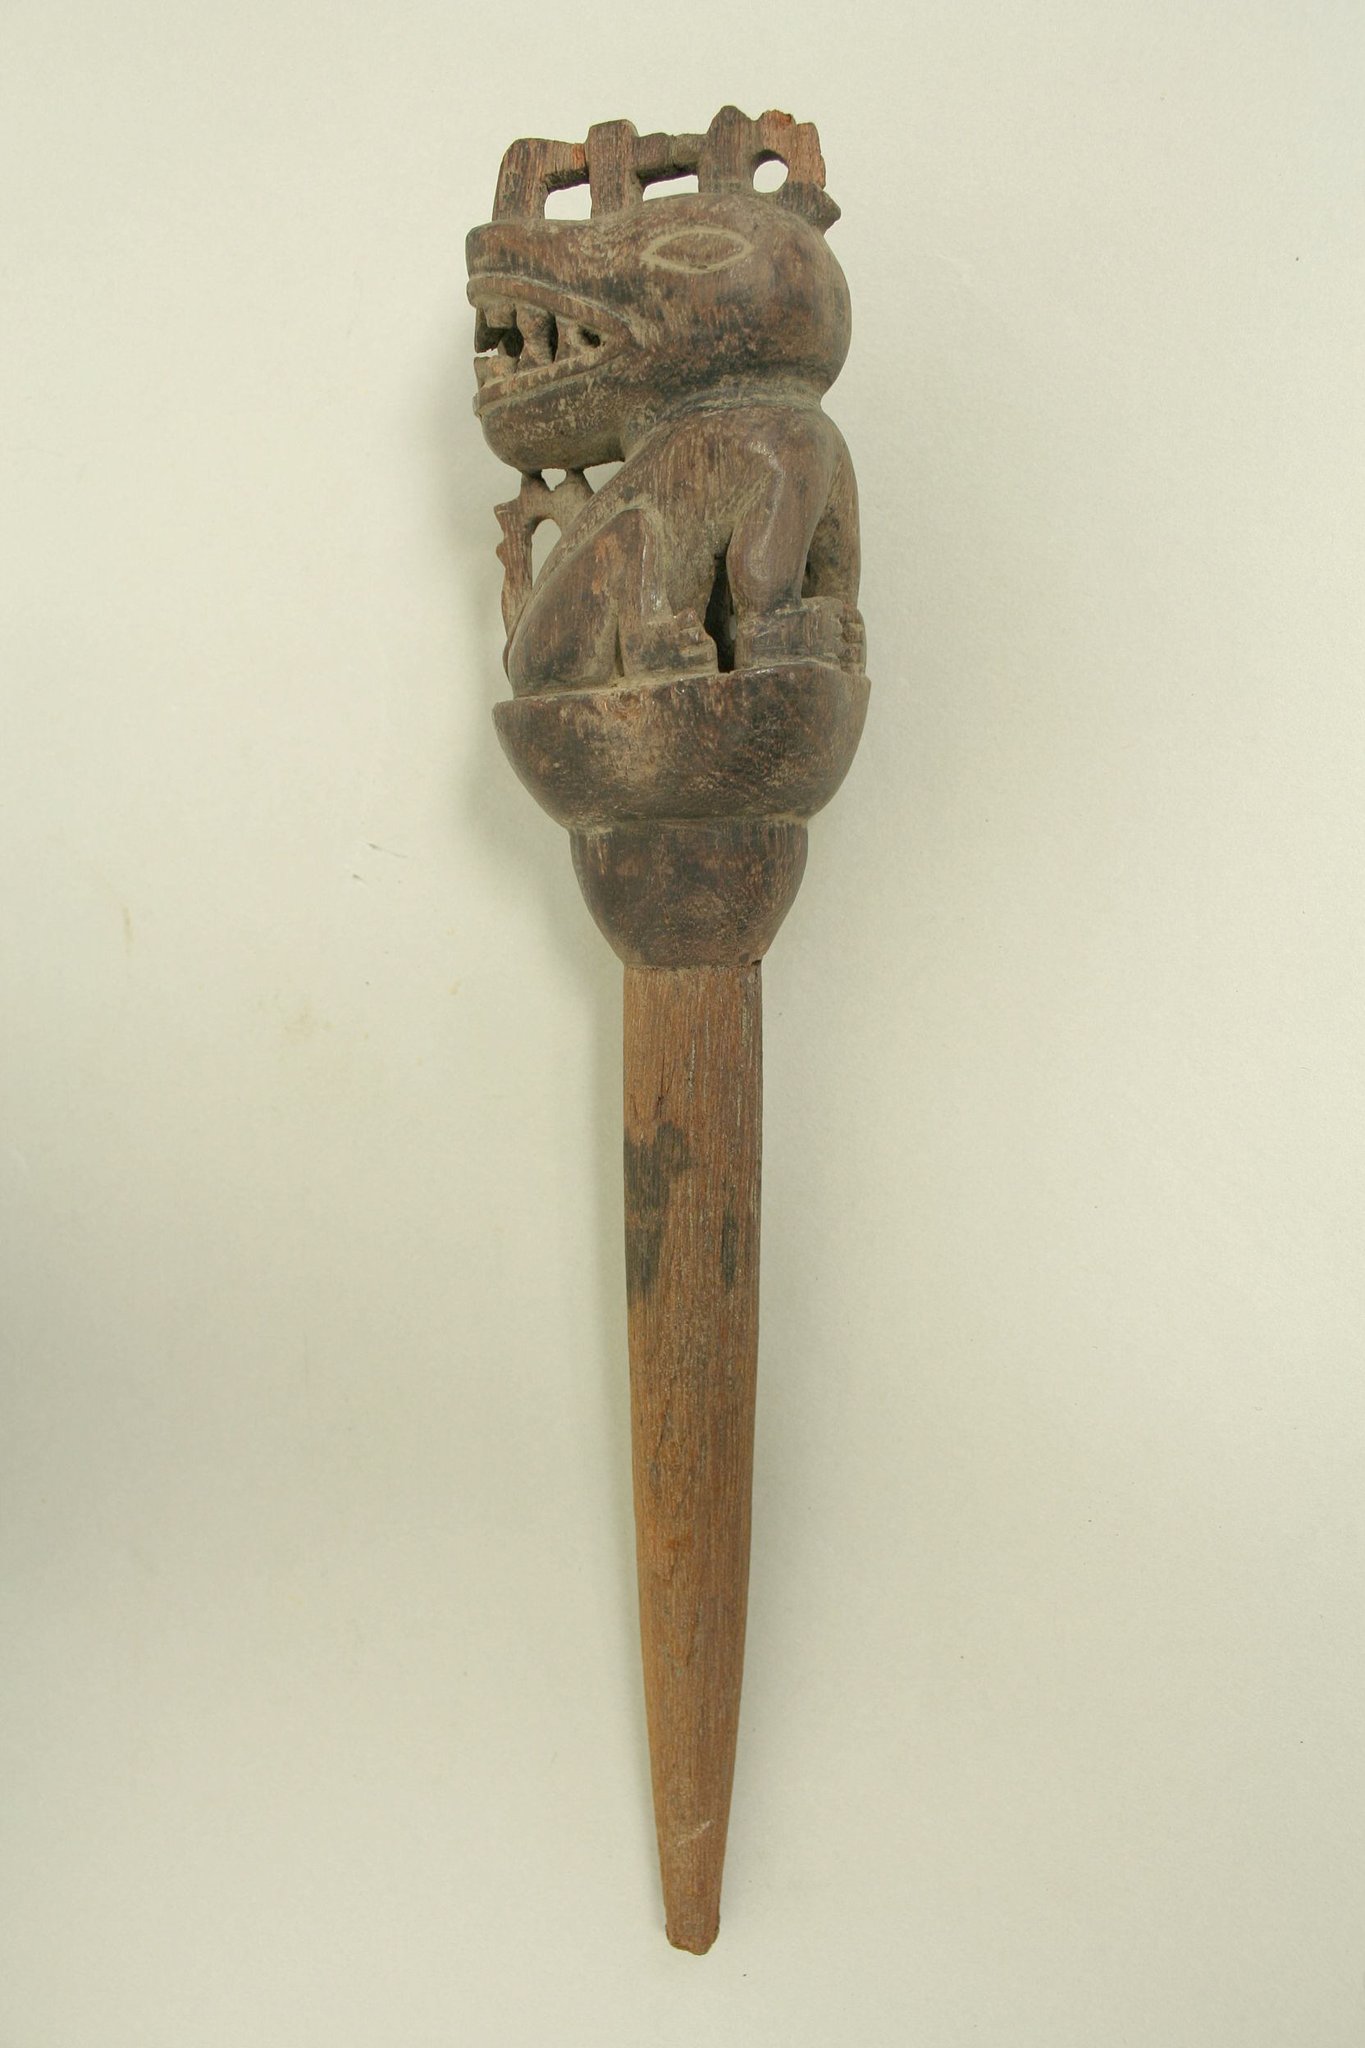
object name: staff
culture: moche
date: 101-700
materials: wood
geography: peru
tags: animals